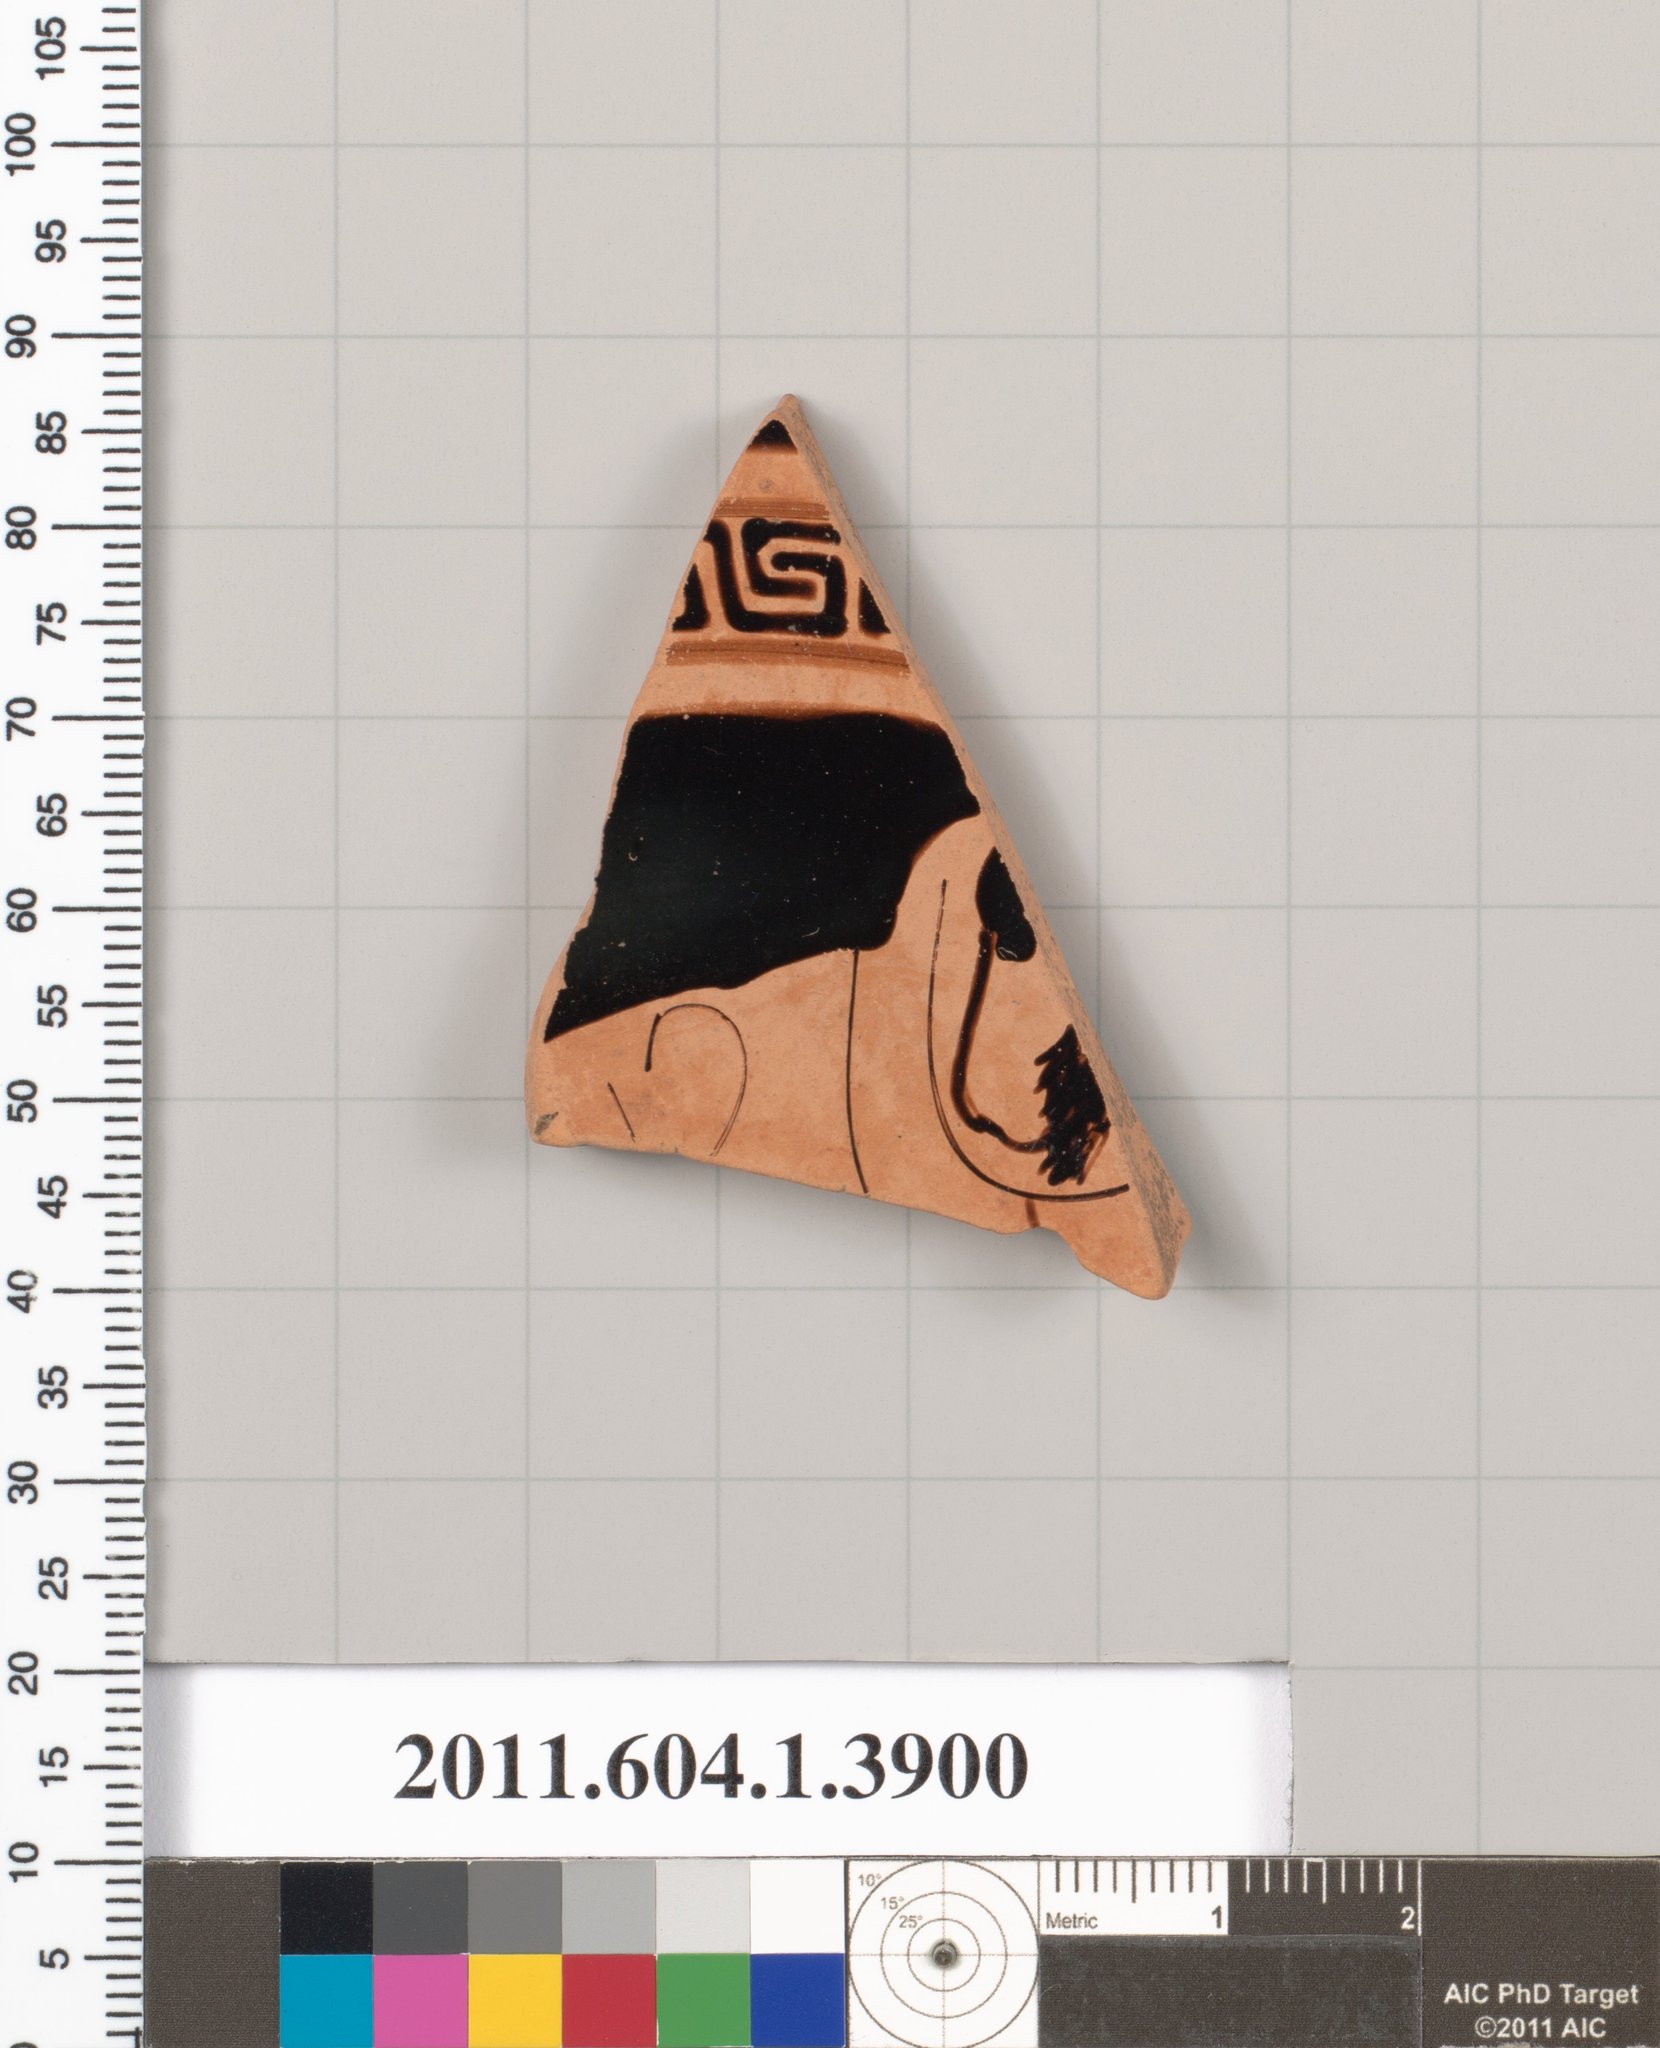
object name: kylix fragment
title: Terracotta fragment of a kylix (drinking cup)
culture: greek, attic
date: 500-470 BCE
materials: terracotta